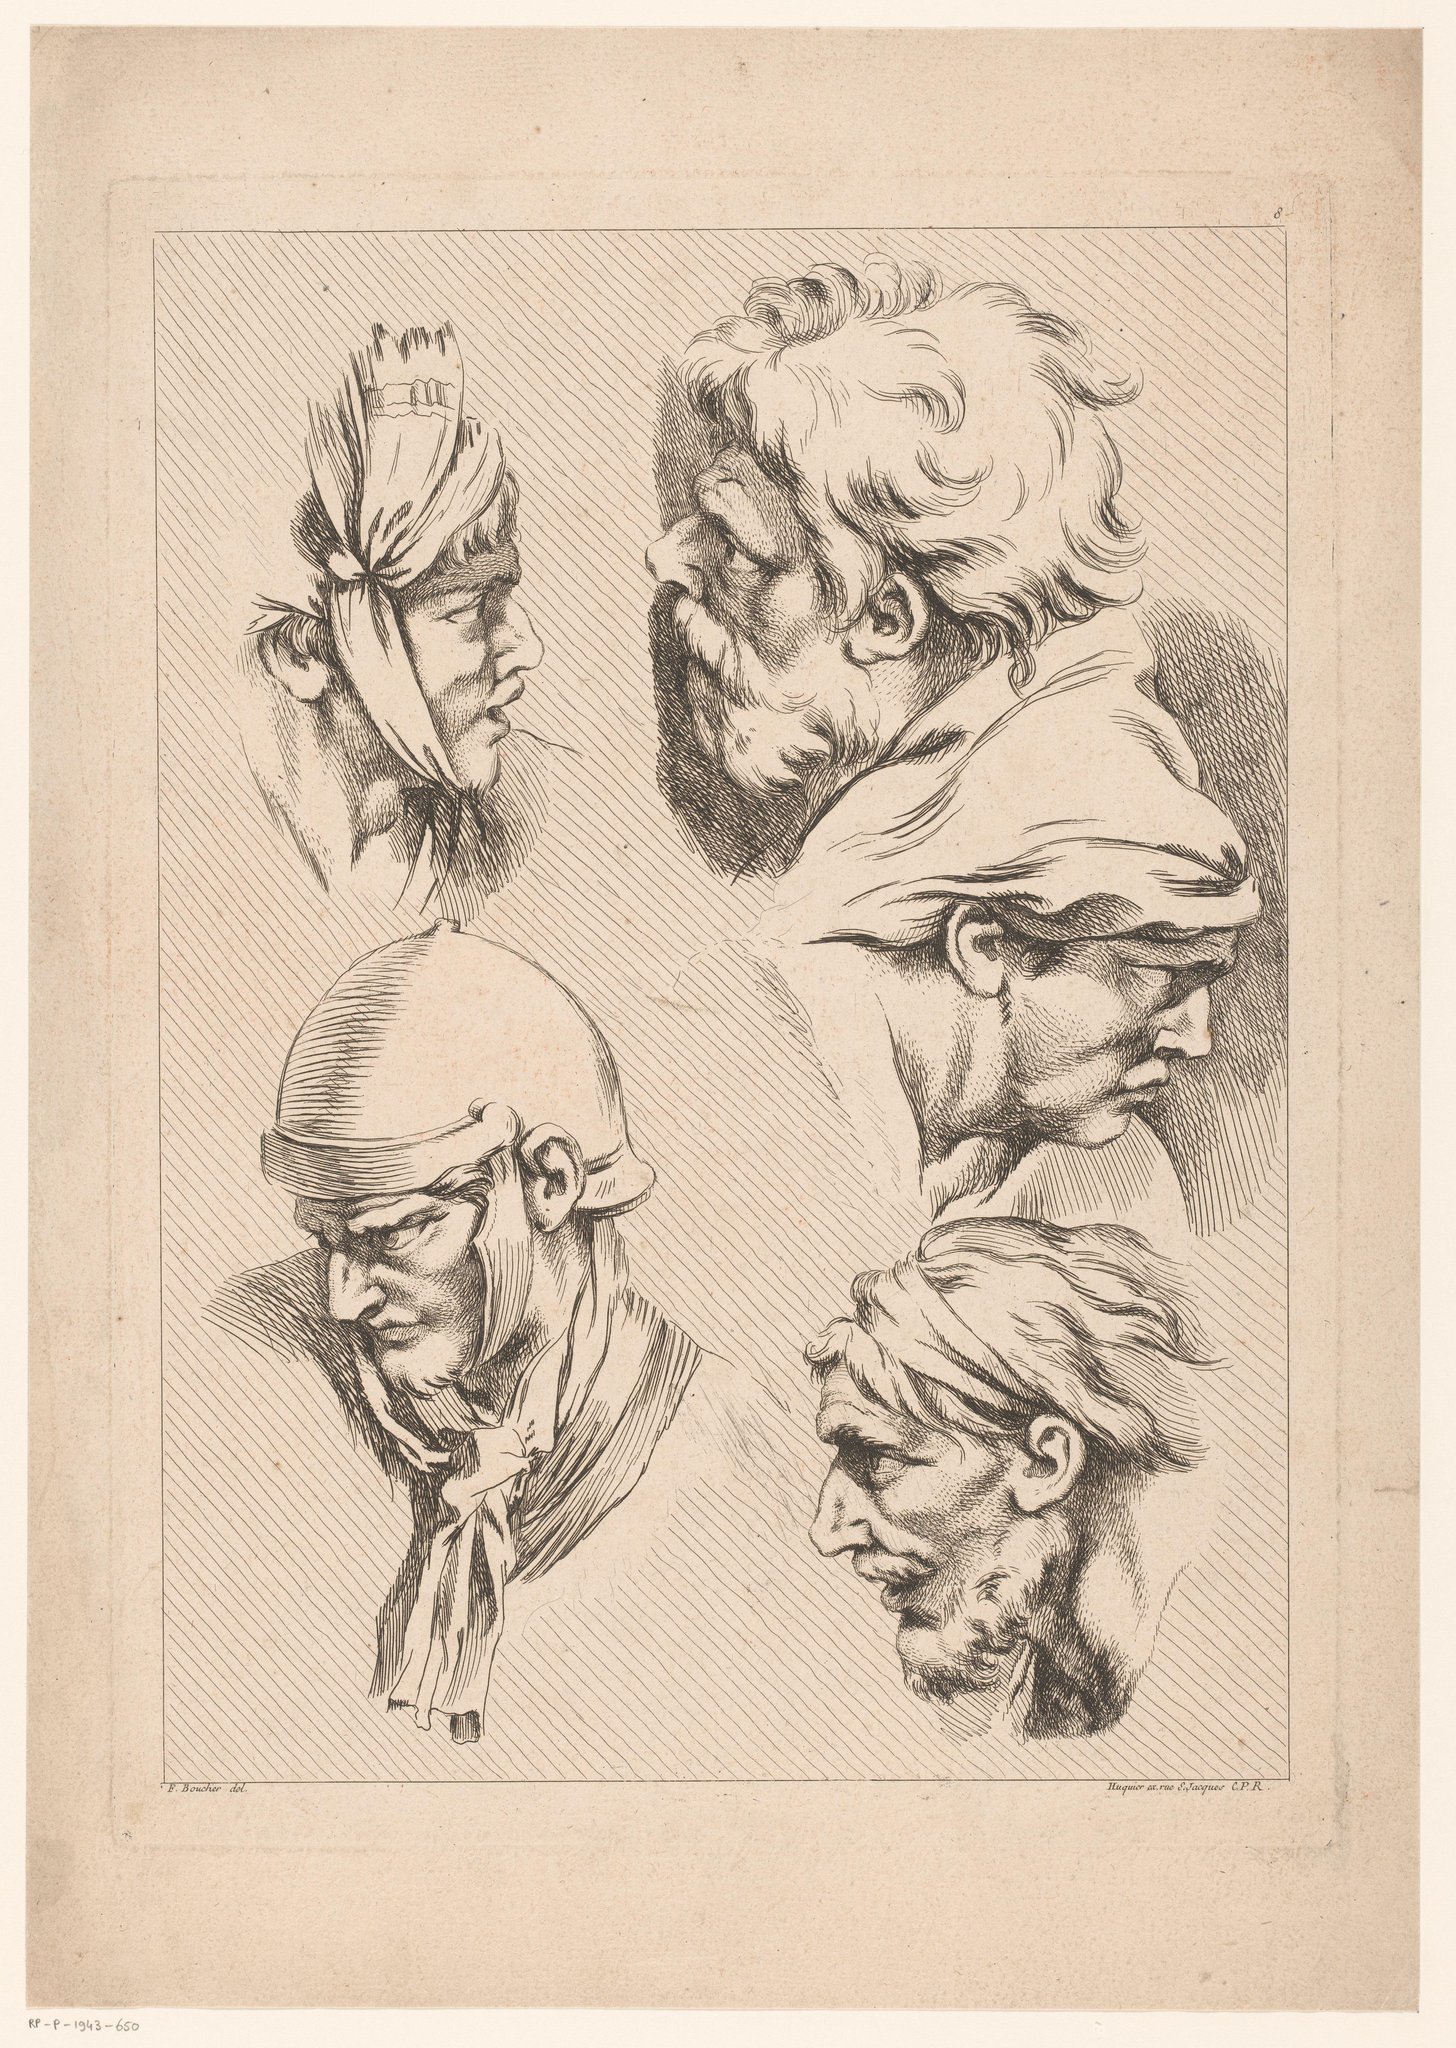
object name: print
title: Compositie met vijf mannenhoofden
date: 1705-1772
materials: paper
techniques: etching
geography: paris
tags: helmet, head (human)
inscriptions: collector's mark: Lugt 2228